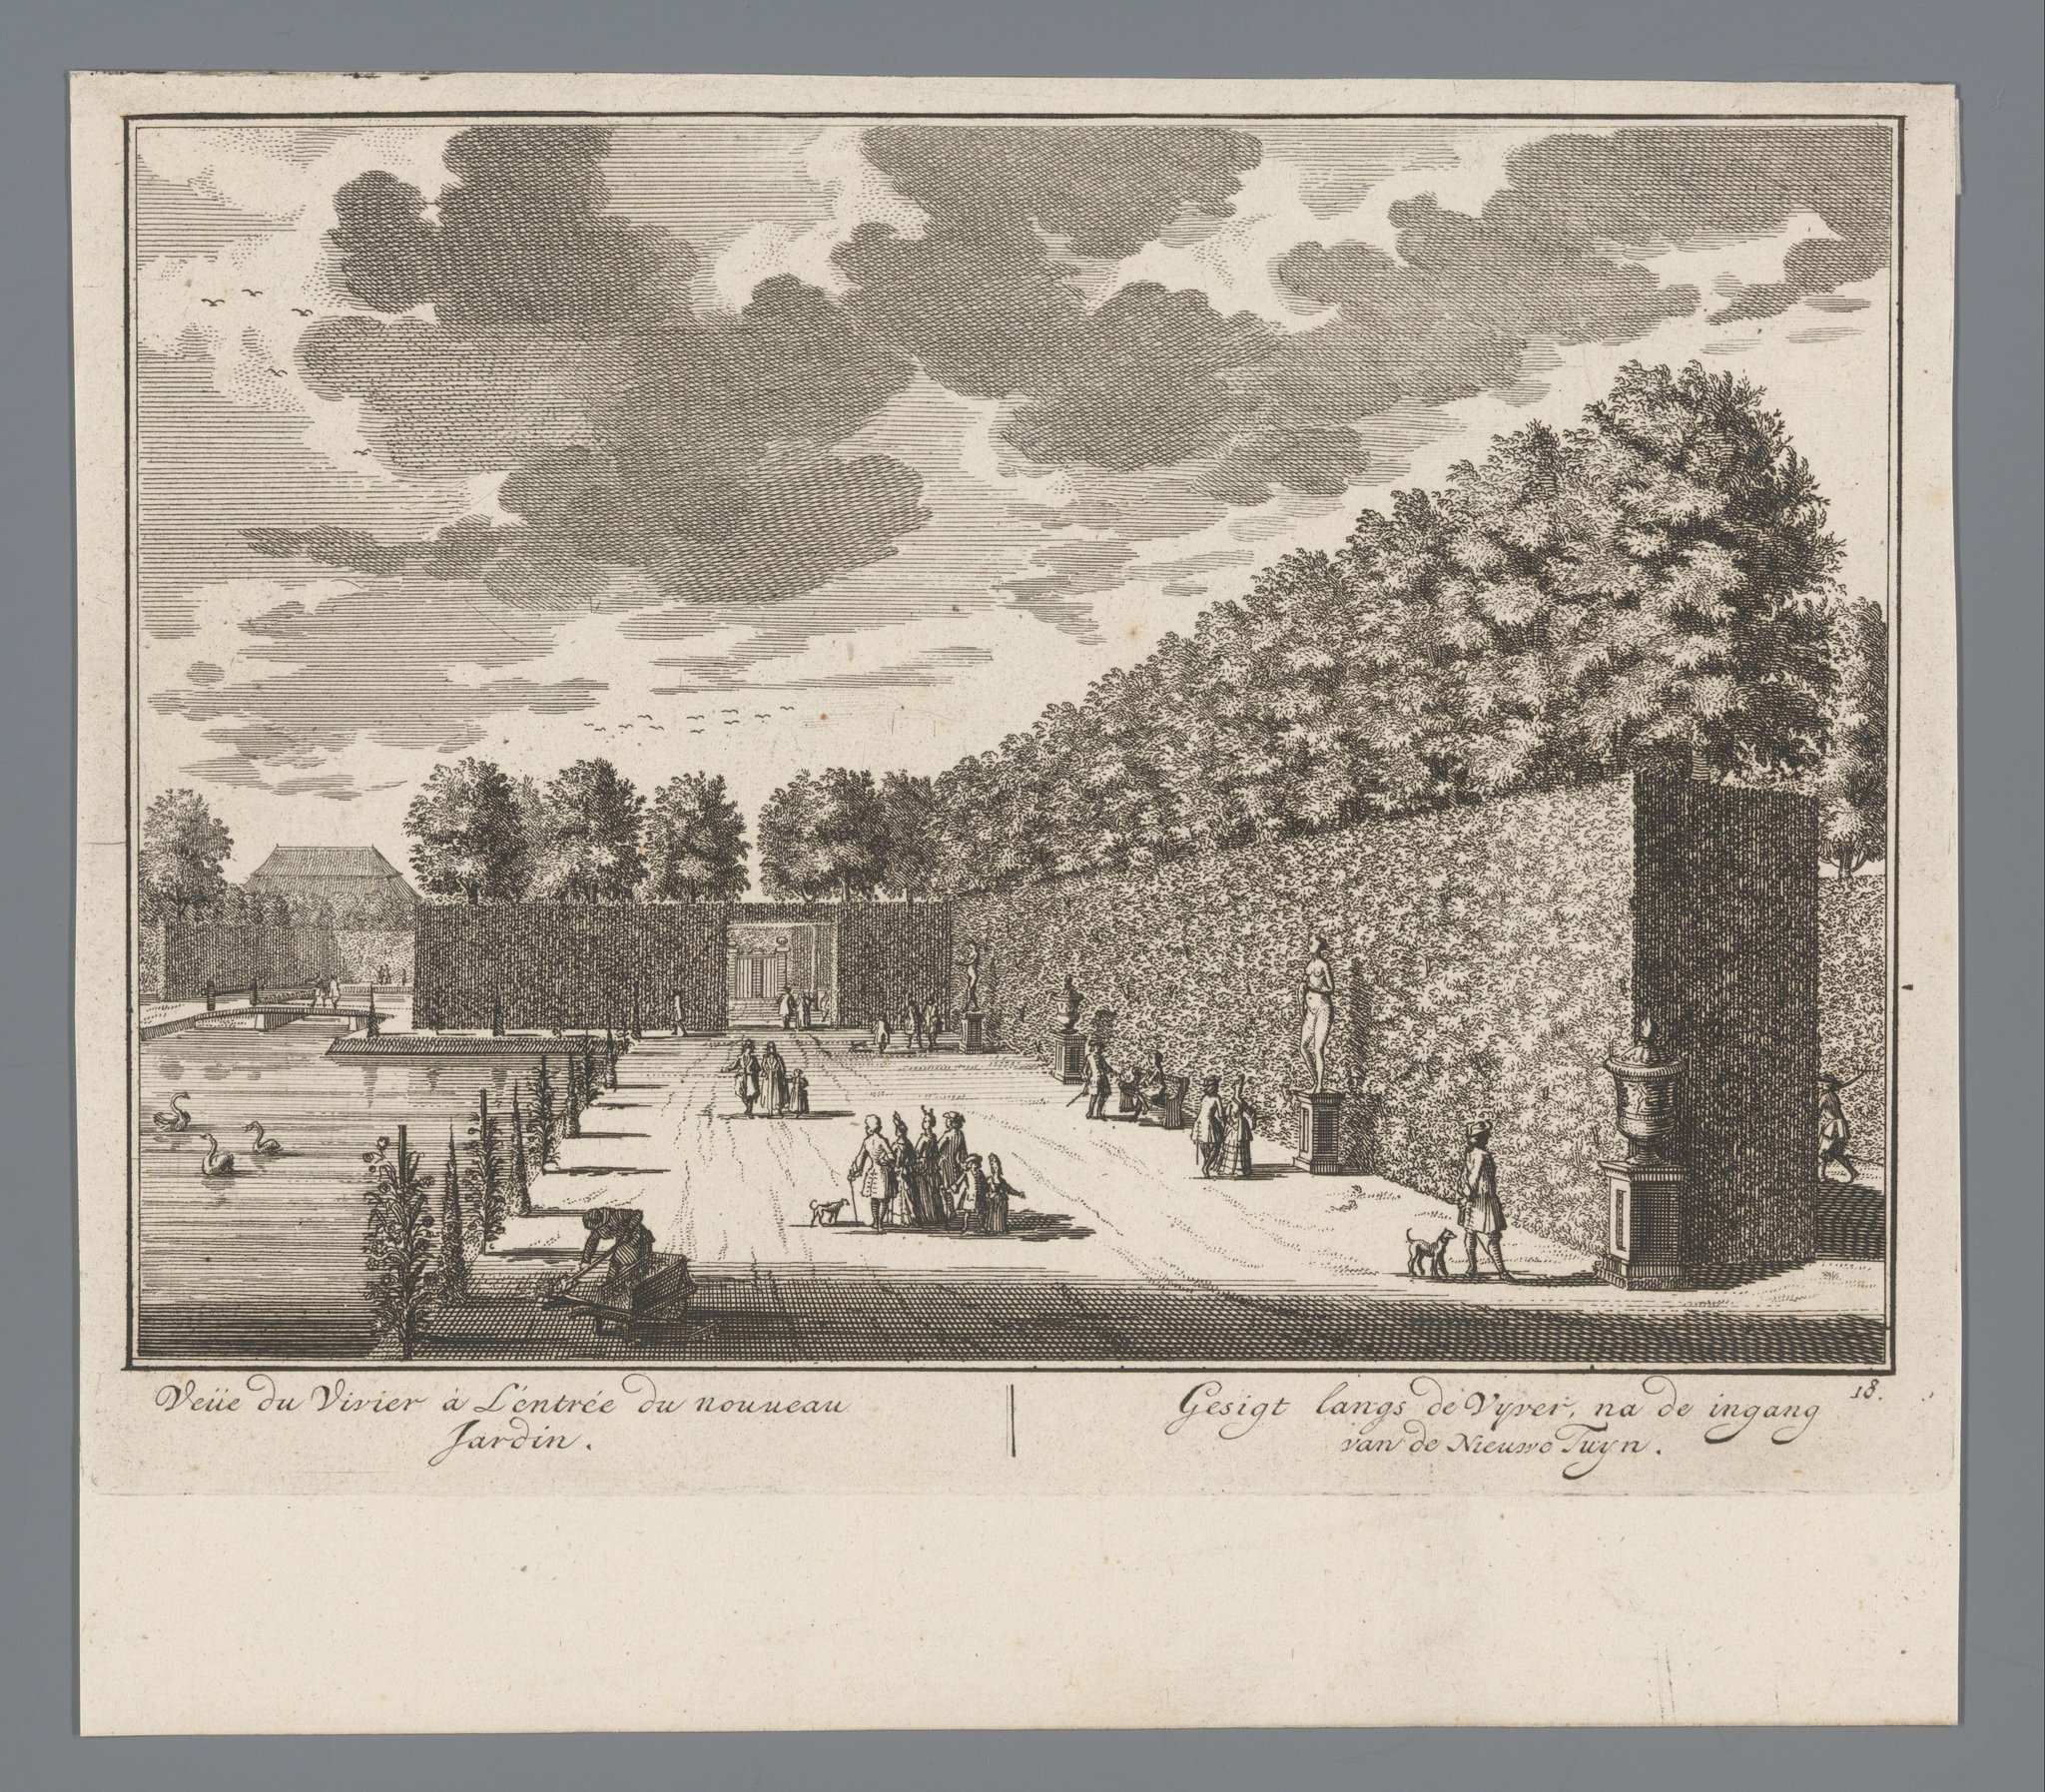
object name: print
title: Gezicht in de tuin van Slot Zeist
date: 1682-1726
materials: paper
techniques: etching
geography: amsterdam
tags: castle, landscape with tower or castle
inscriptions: collector's mark: Lugt 2233